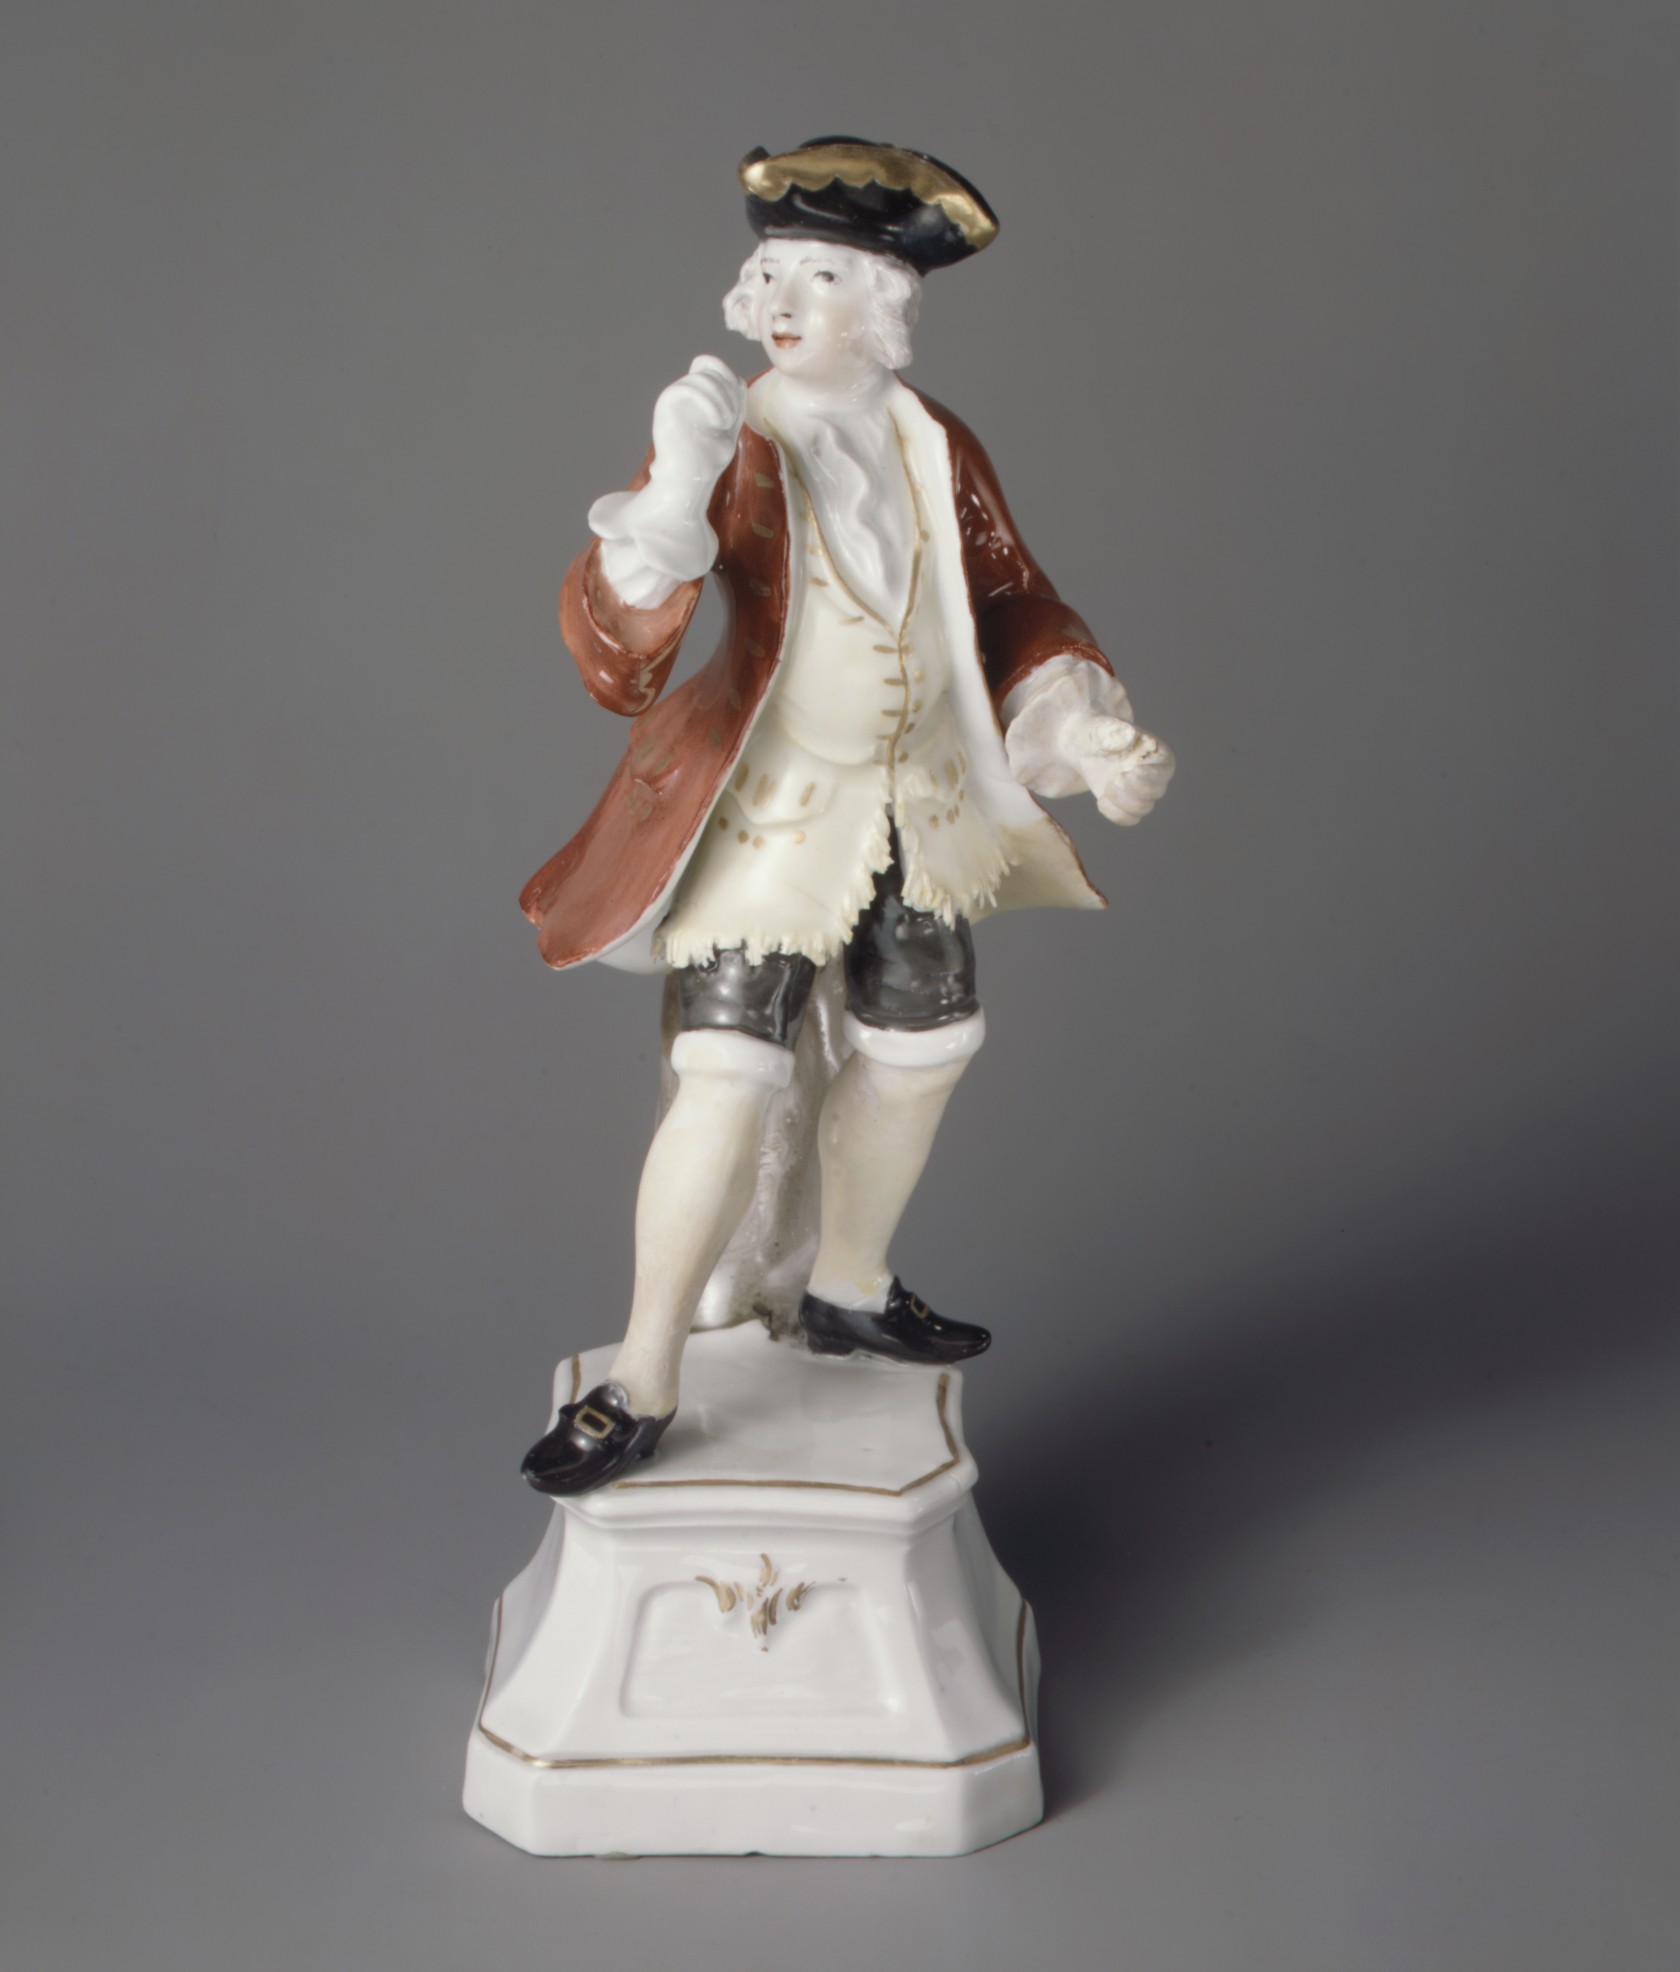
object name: figure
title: Cynthio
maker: höchst manufactory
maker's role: manufactory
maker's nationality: german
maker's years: 1746-1796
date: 1750-1755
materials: hard paste porcelain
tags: men